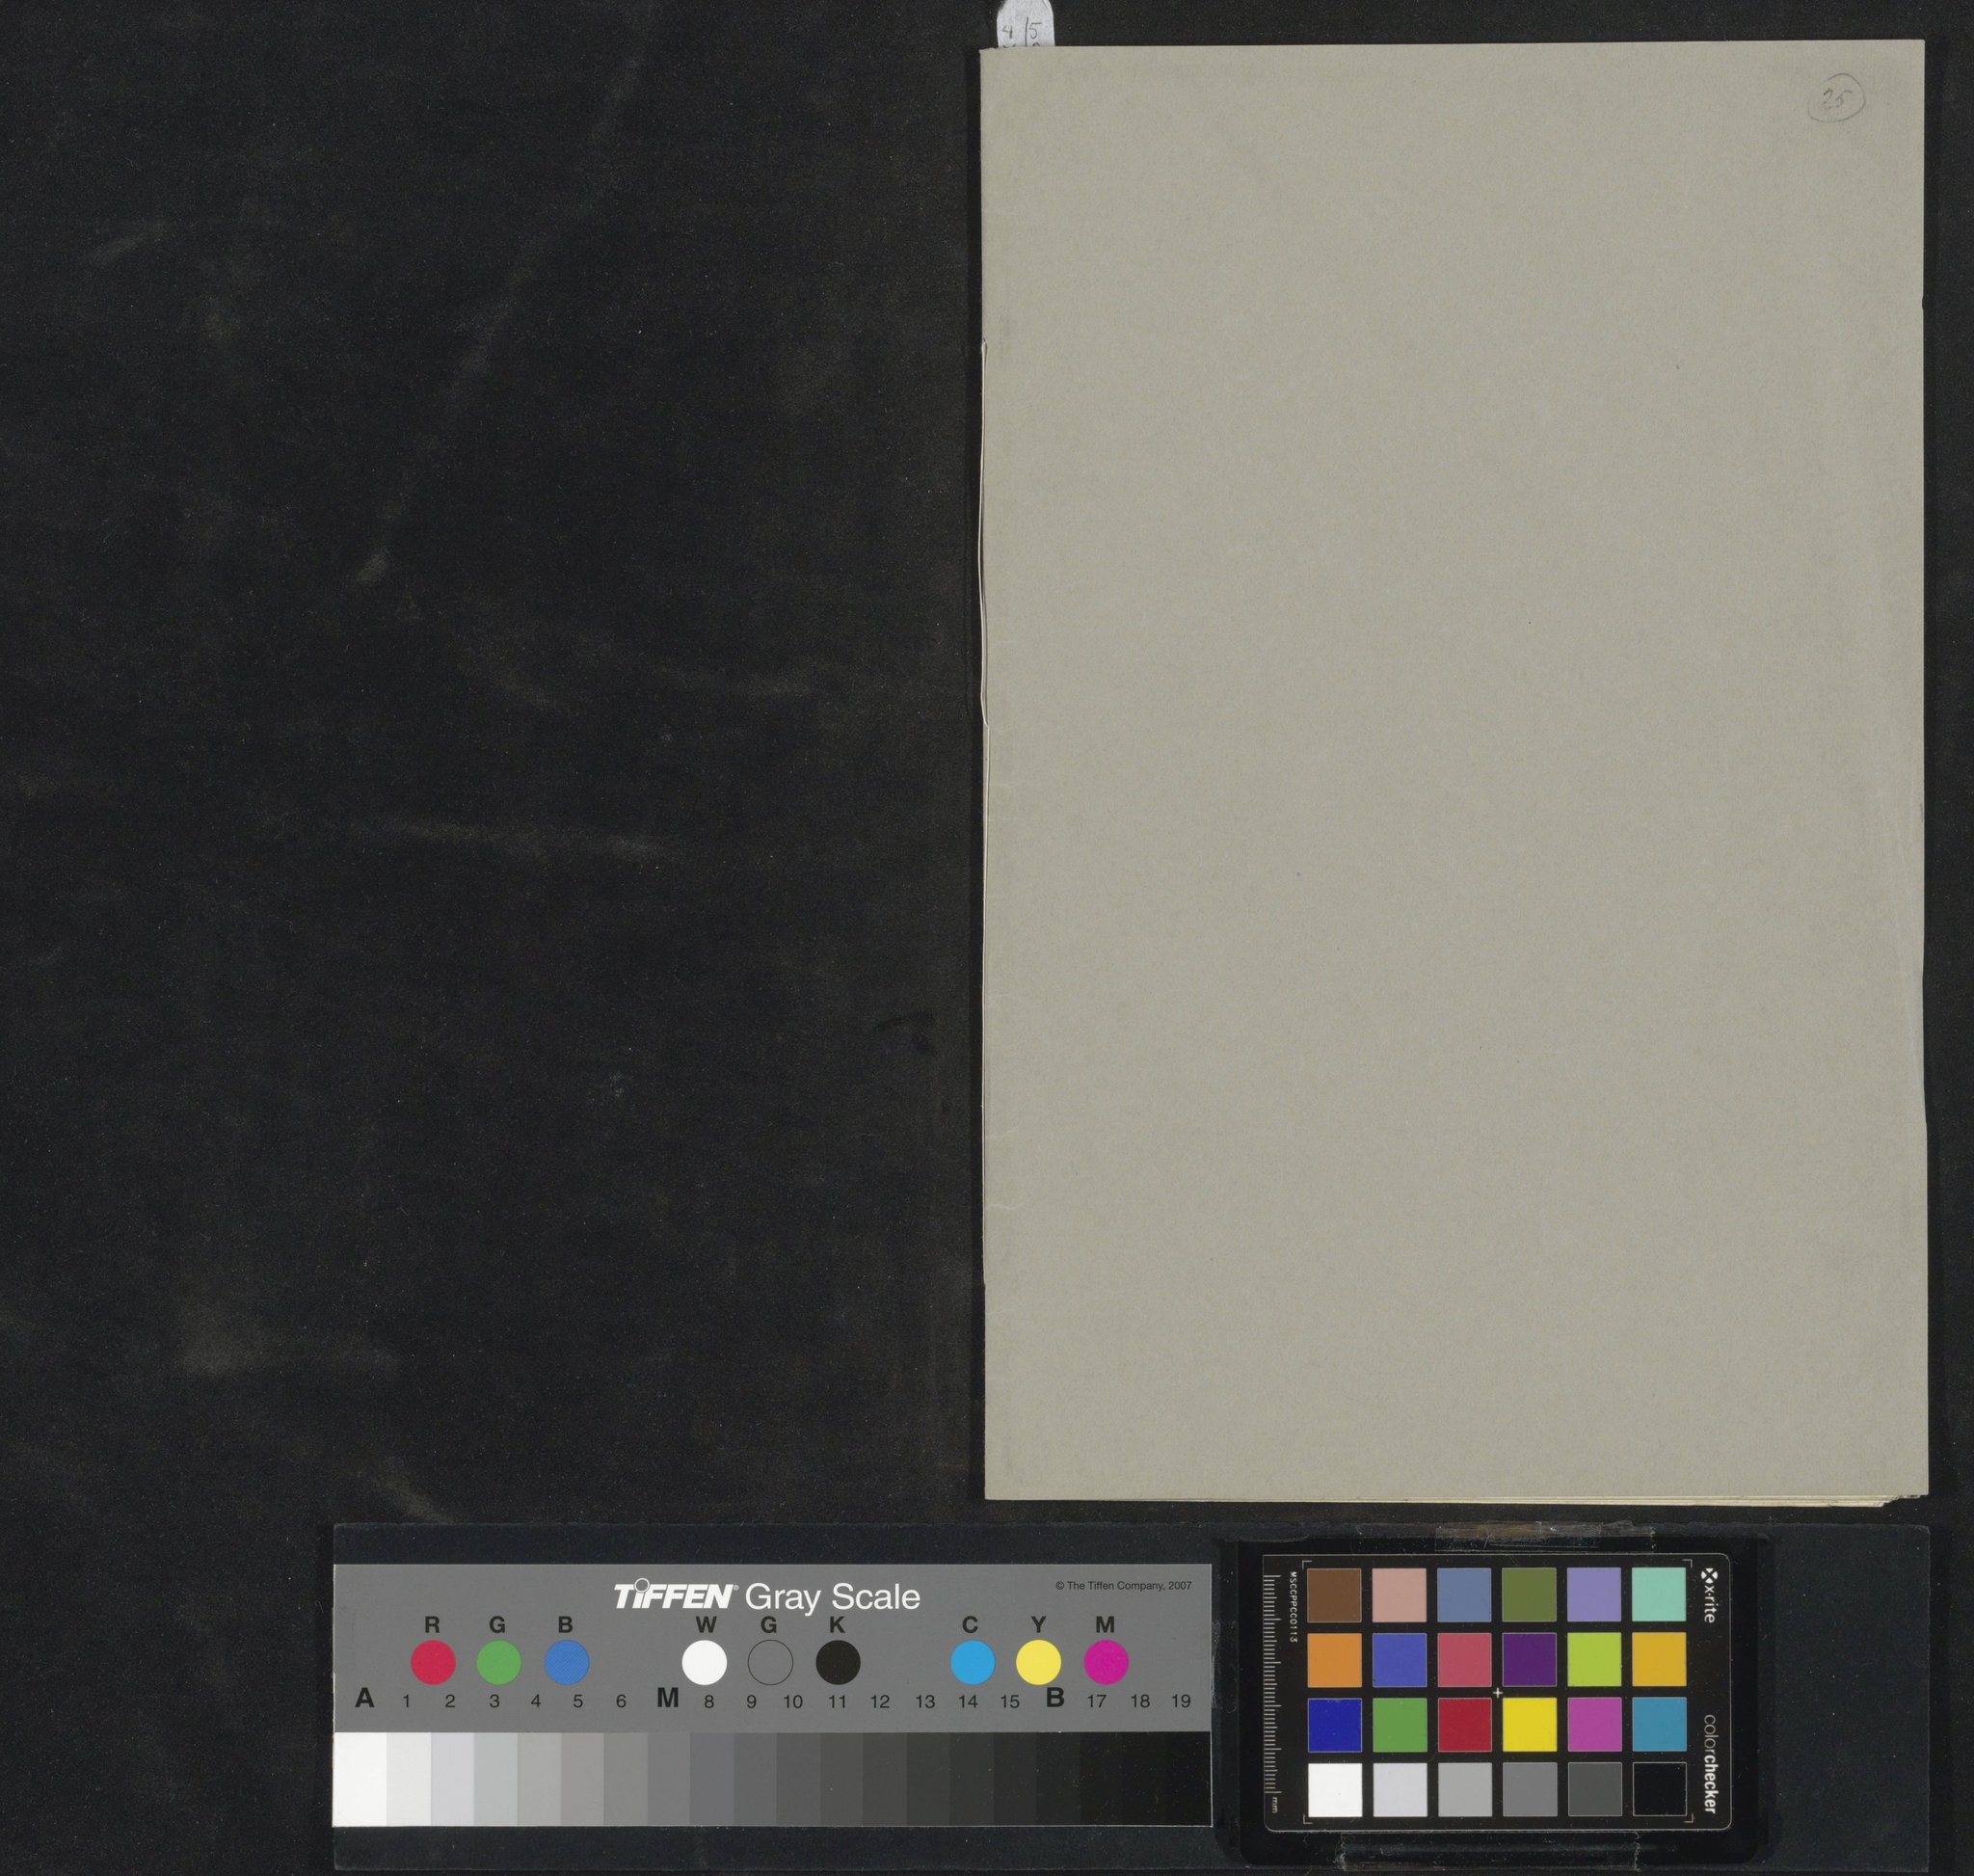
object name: sketchbook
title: Schetsboek met 9 bladen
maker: carel adolph lion cachet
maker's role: draughtsman, print maker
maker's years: 1864-1945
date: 1874-1945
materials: chalk, ink, pencil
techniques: pen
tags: ornaments ~ art, lighting; lamps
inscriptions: collector's mark: Lugt 2228a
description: Schetsboek bestaande uit 9 bladen met ornamenten en ontwerpen voor hanglampen.